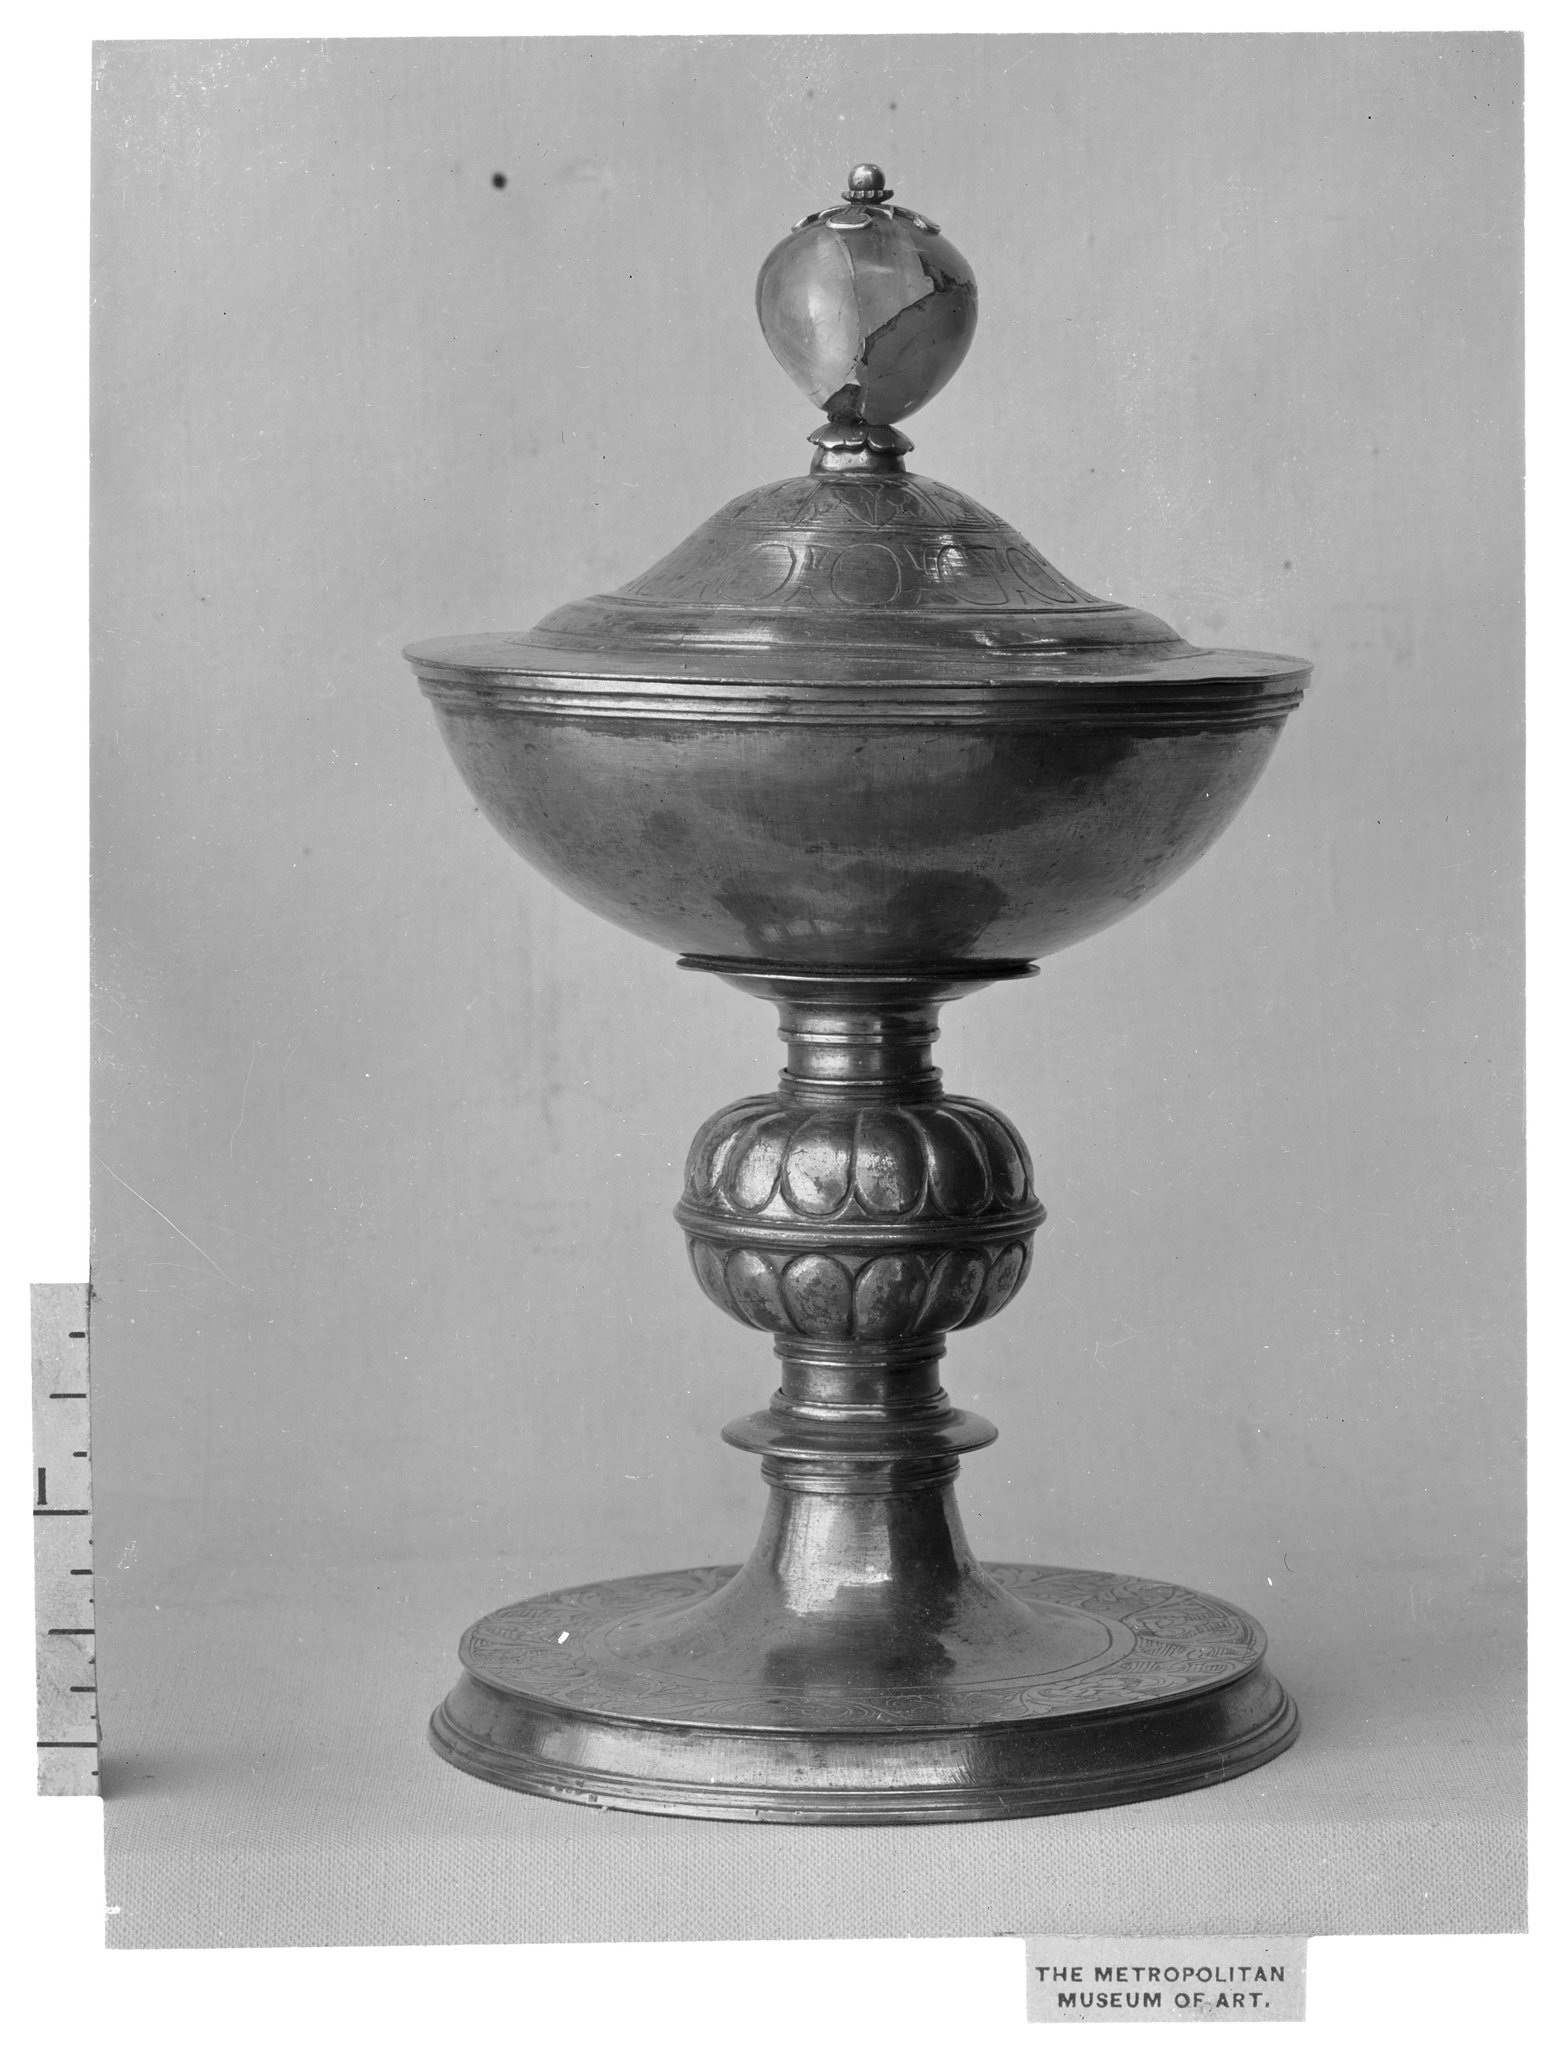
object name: ciborium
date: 1601-1700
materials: gemstone, copper gilt